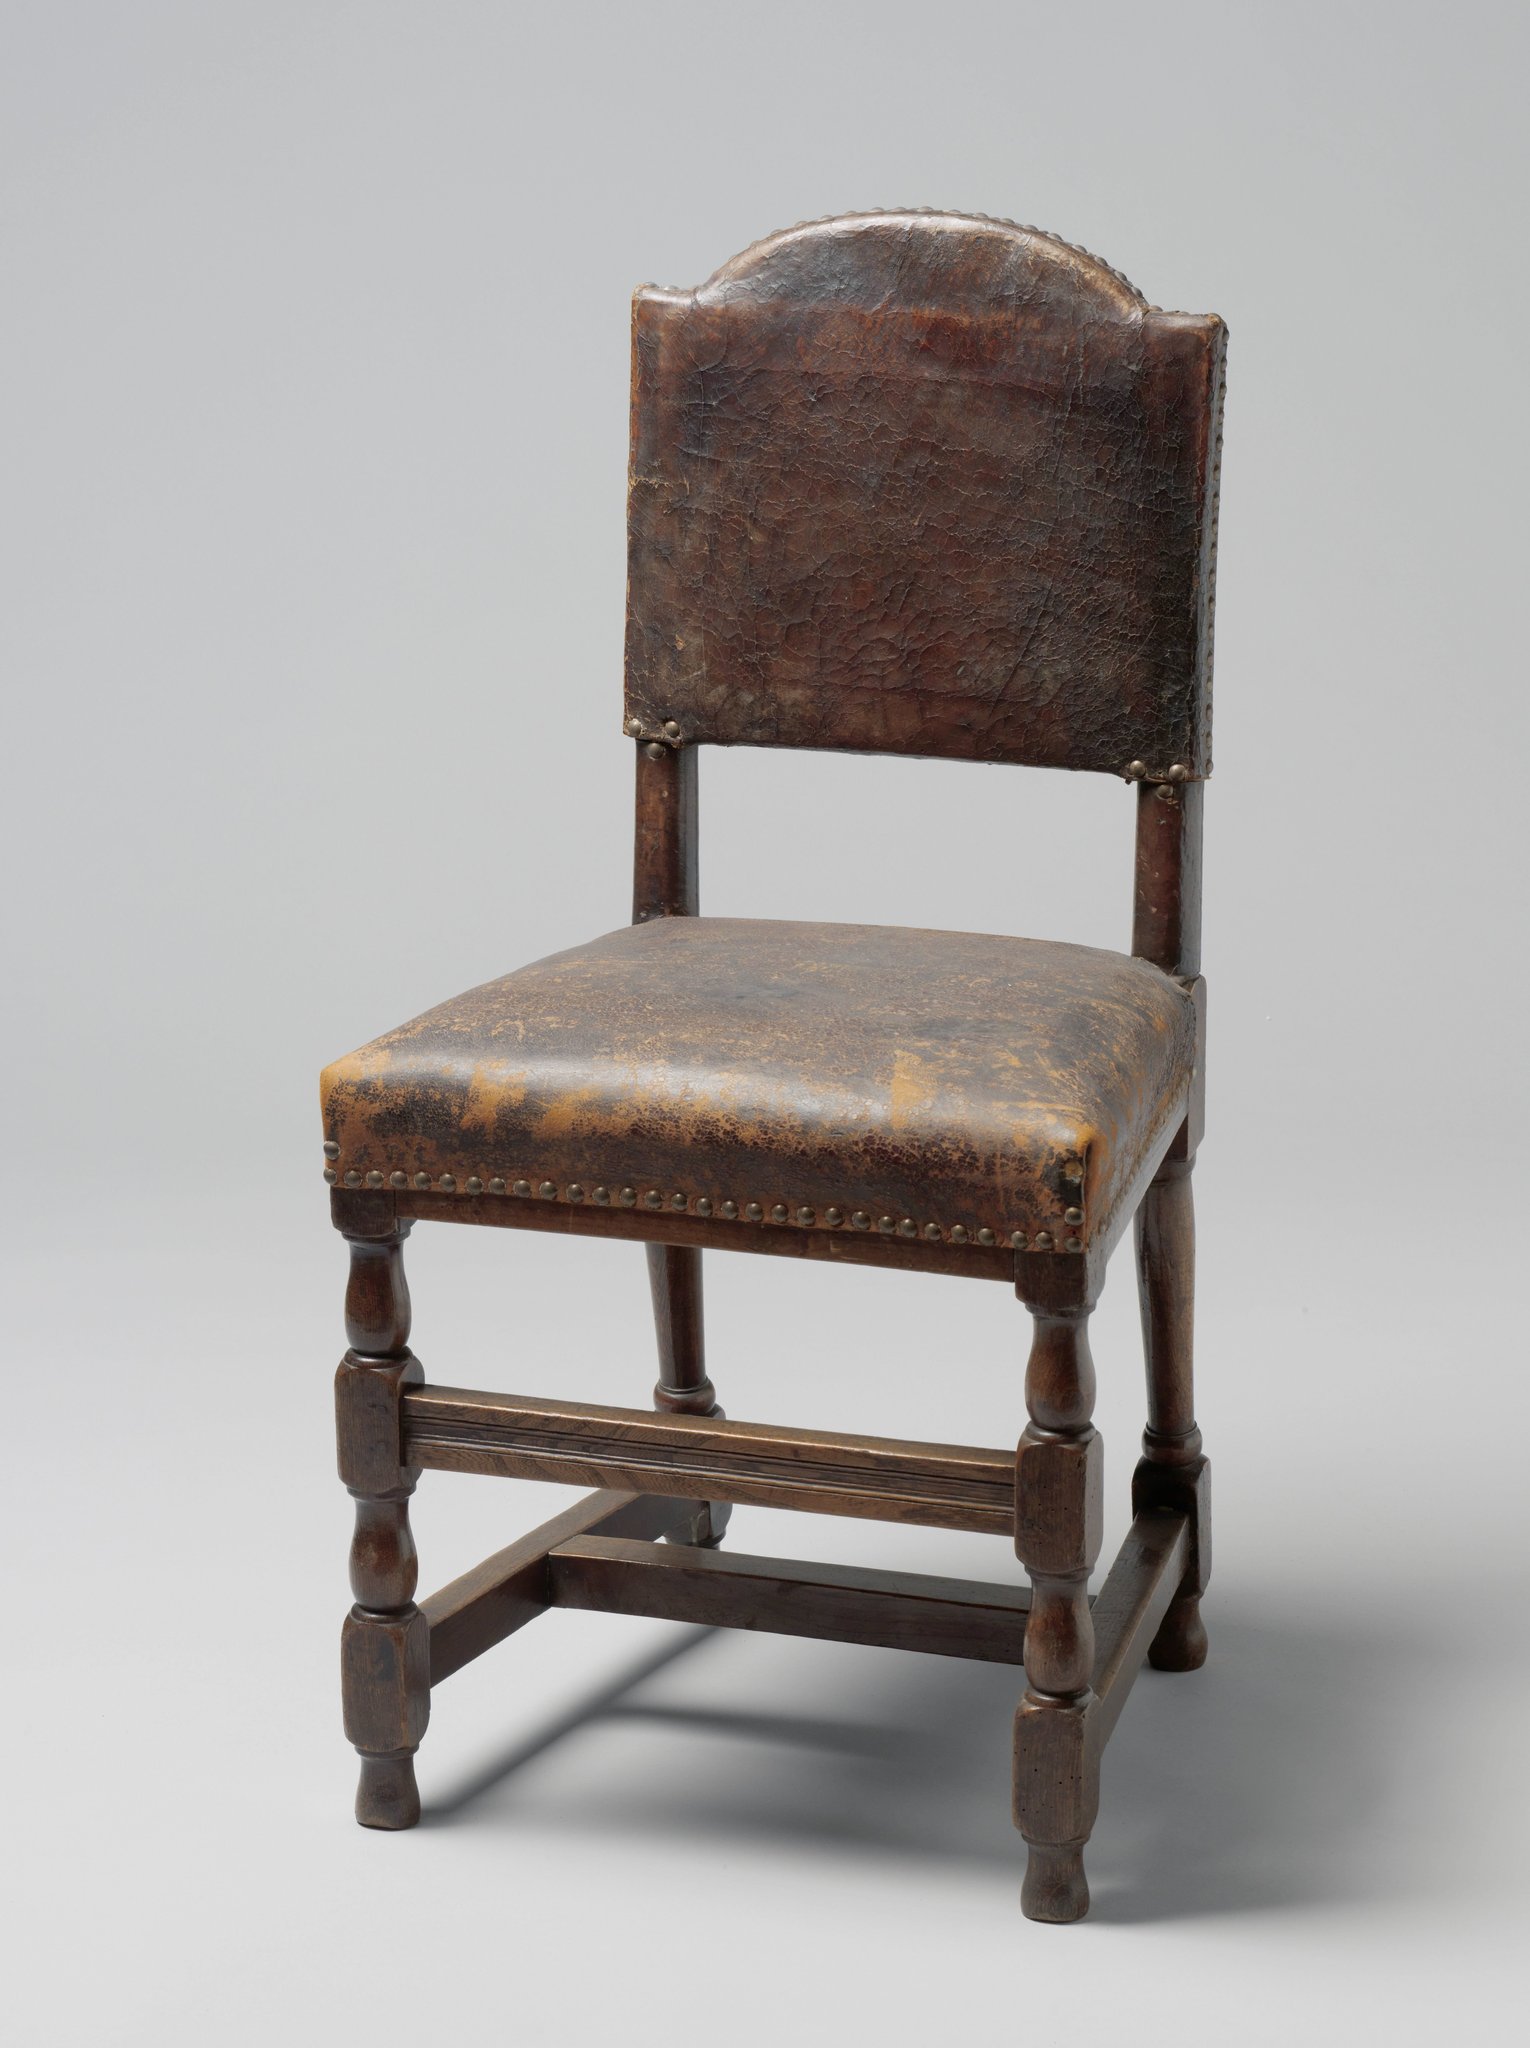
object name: chair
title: Stoel van eikenhout met zitting en rug van leer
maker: Anonymous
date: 1675-1700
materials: wood, leather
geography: northern netherlands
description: Acht eikenhouten stoelen met leren zitting en rug. De poten vertonen huis en geleden en zijn verbonden door een H-vormig kruis. Aan de voorzijde bevindt zich, tussen twee huizen, een brede voorsport. De achterpoten wijken naar achteren. De rug rust hoog op de stutten en is van boven gebogen.